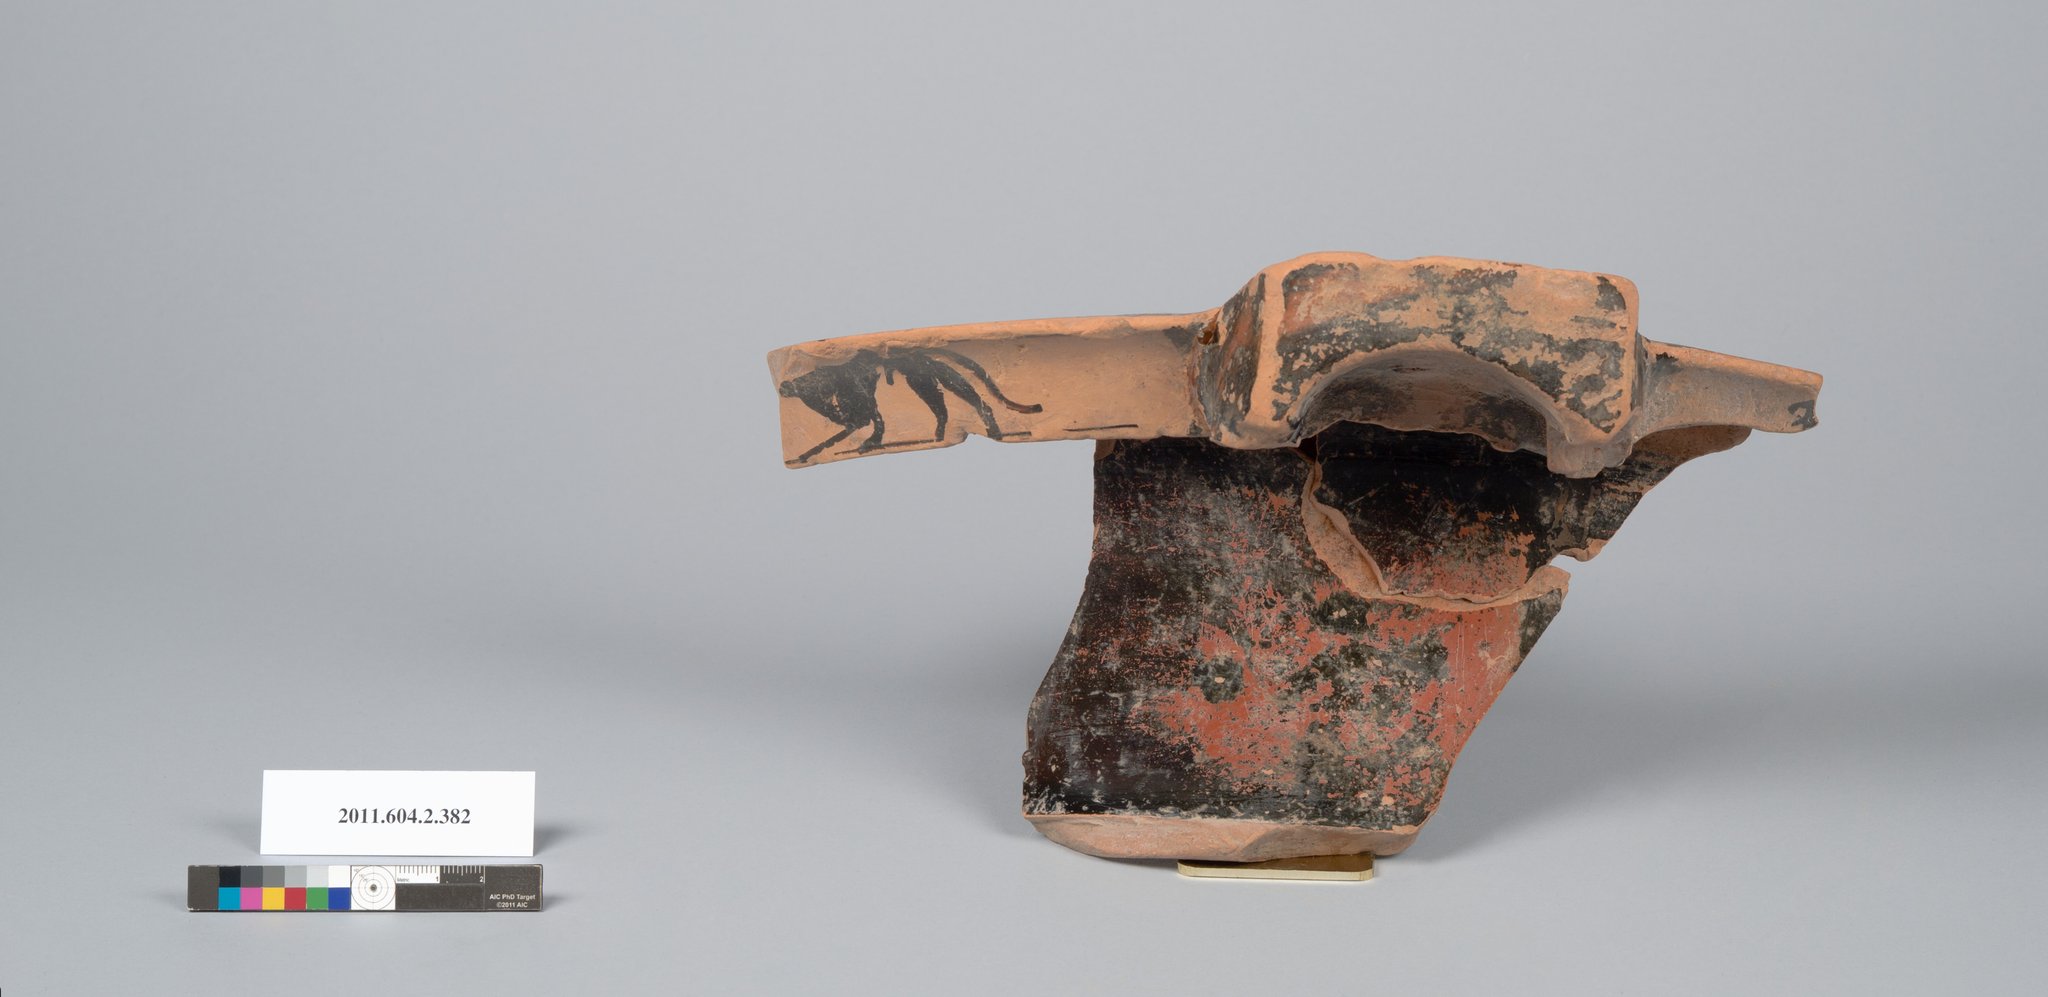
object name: column krater fragment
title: Terracotta fragment of a column-krater (bowl for mixing wine and water)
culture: greek, attic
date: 467-435 BCE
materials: terracotta